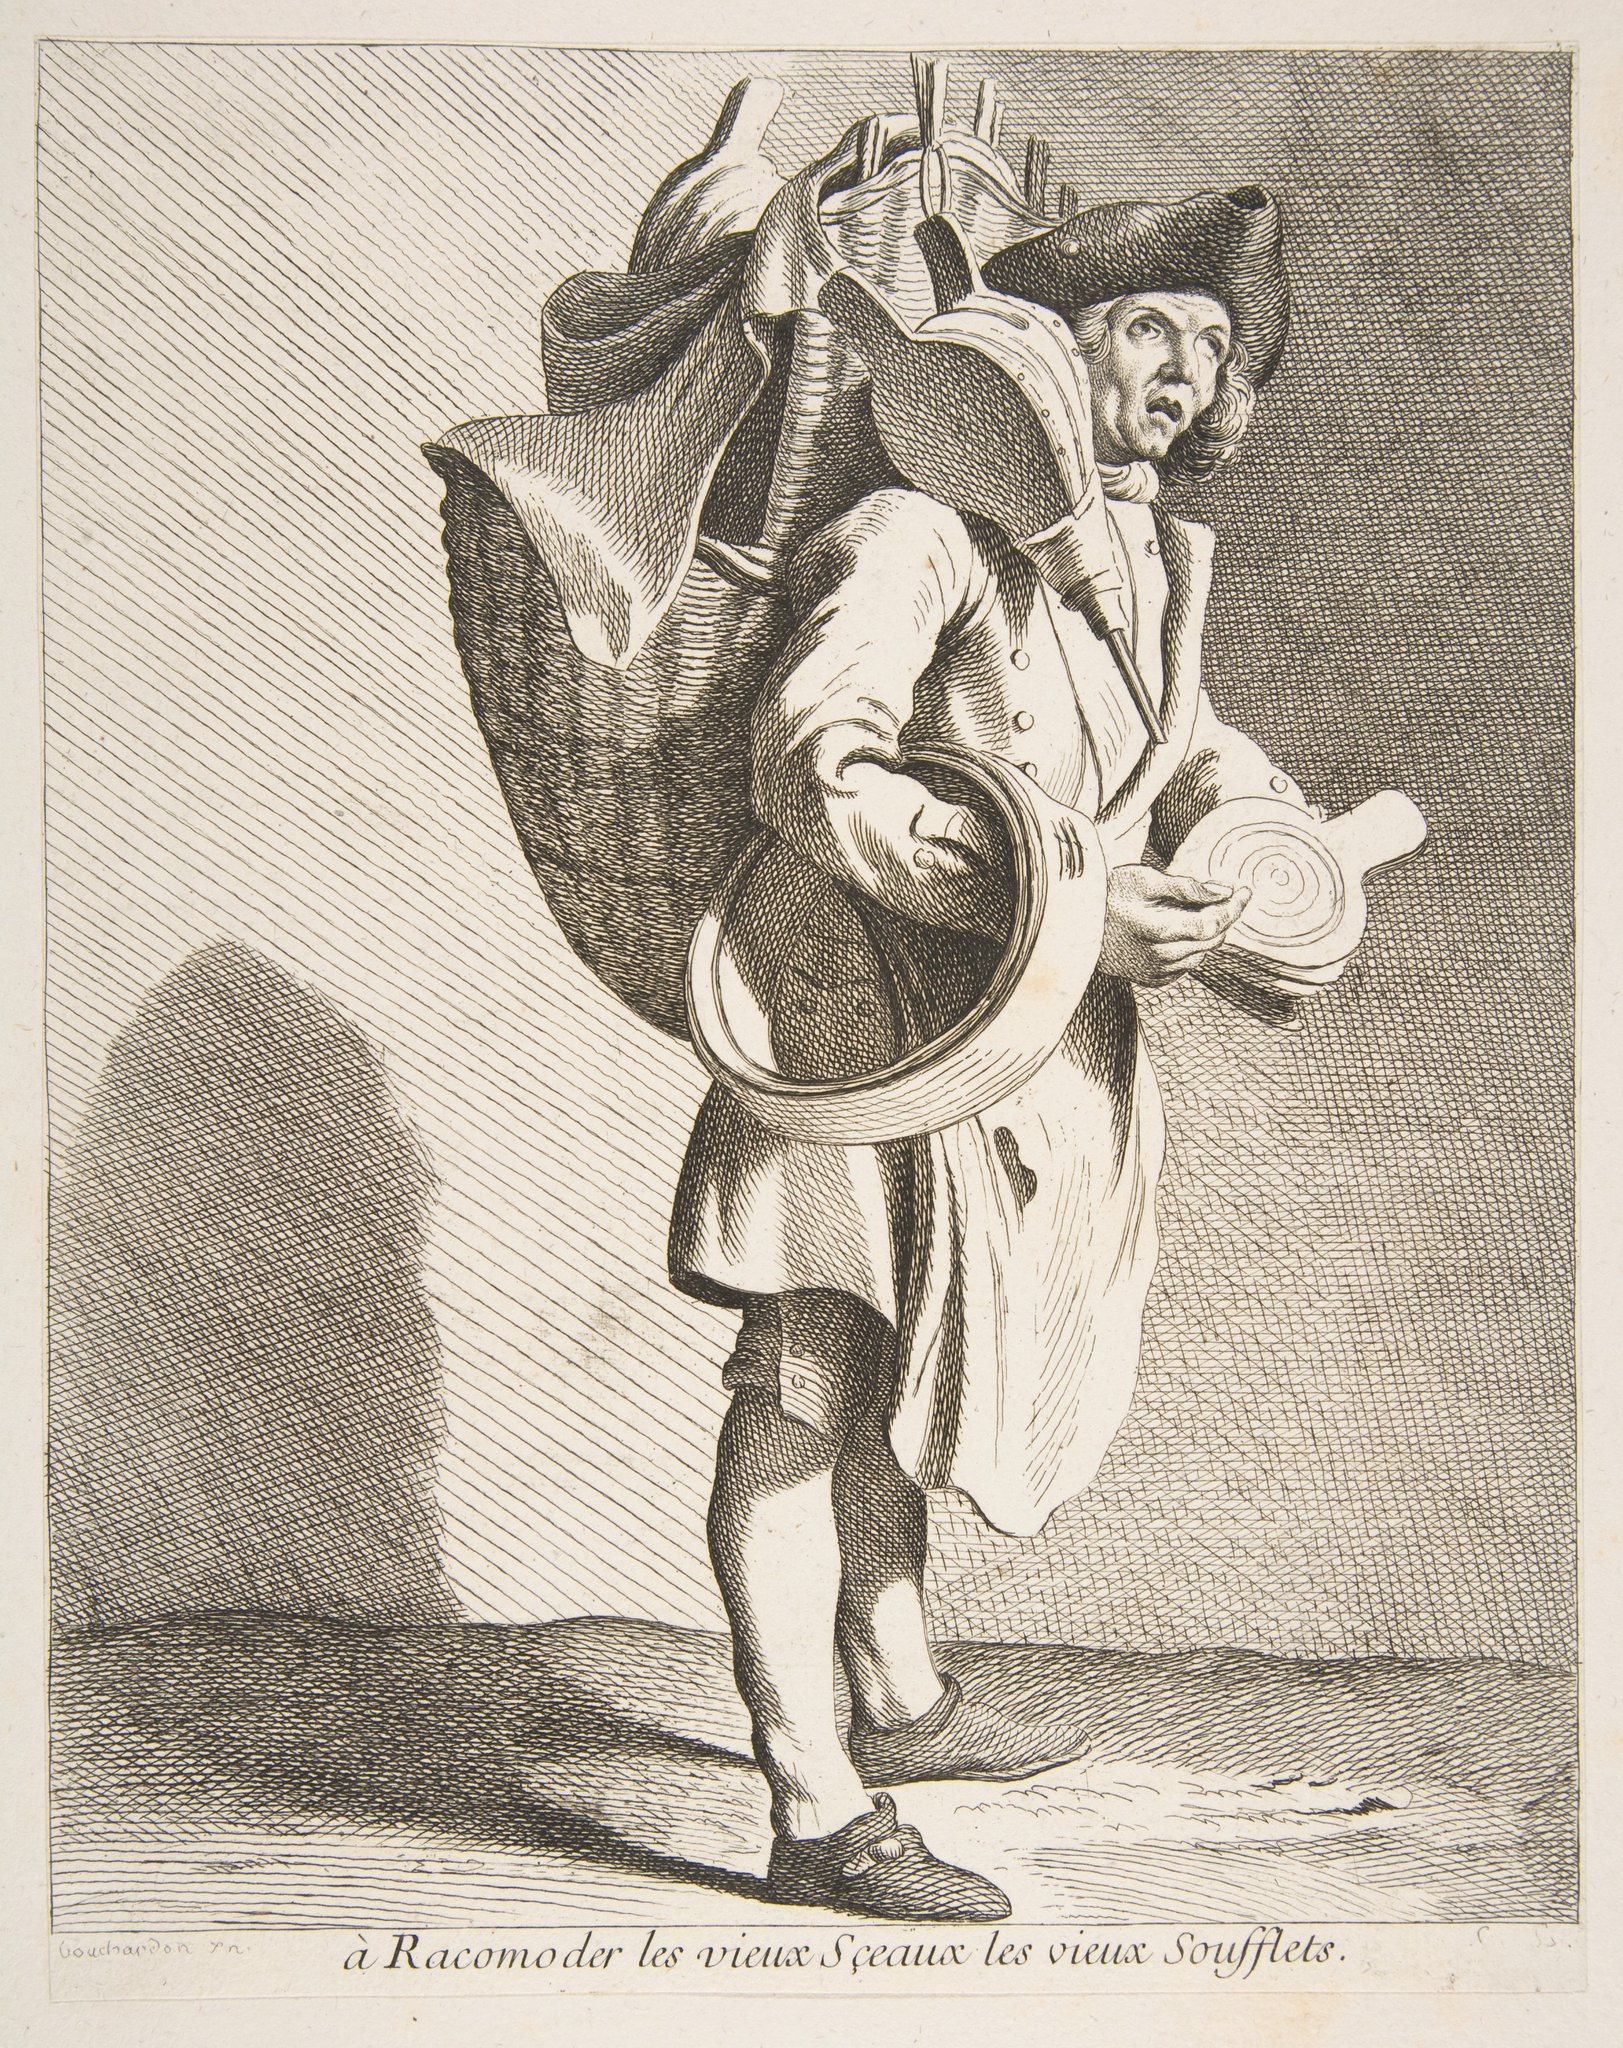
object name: print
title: Repairer of Seals and Bellows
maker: anne claude philippe de tubières, comte de caylus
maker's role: artist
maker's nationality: french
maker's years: 1692-1765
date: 1738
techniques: engraving, etching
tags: men,bellows